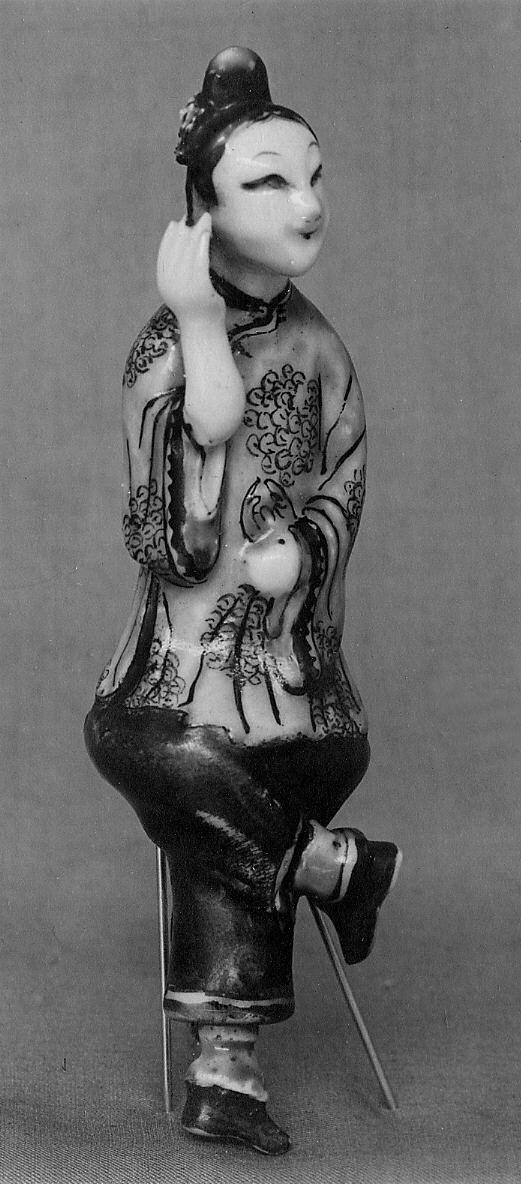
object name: snuff bottle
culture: chinese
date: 1736-1795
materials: porcelain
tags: women